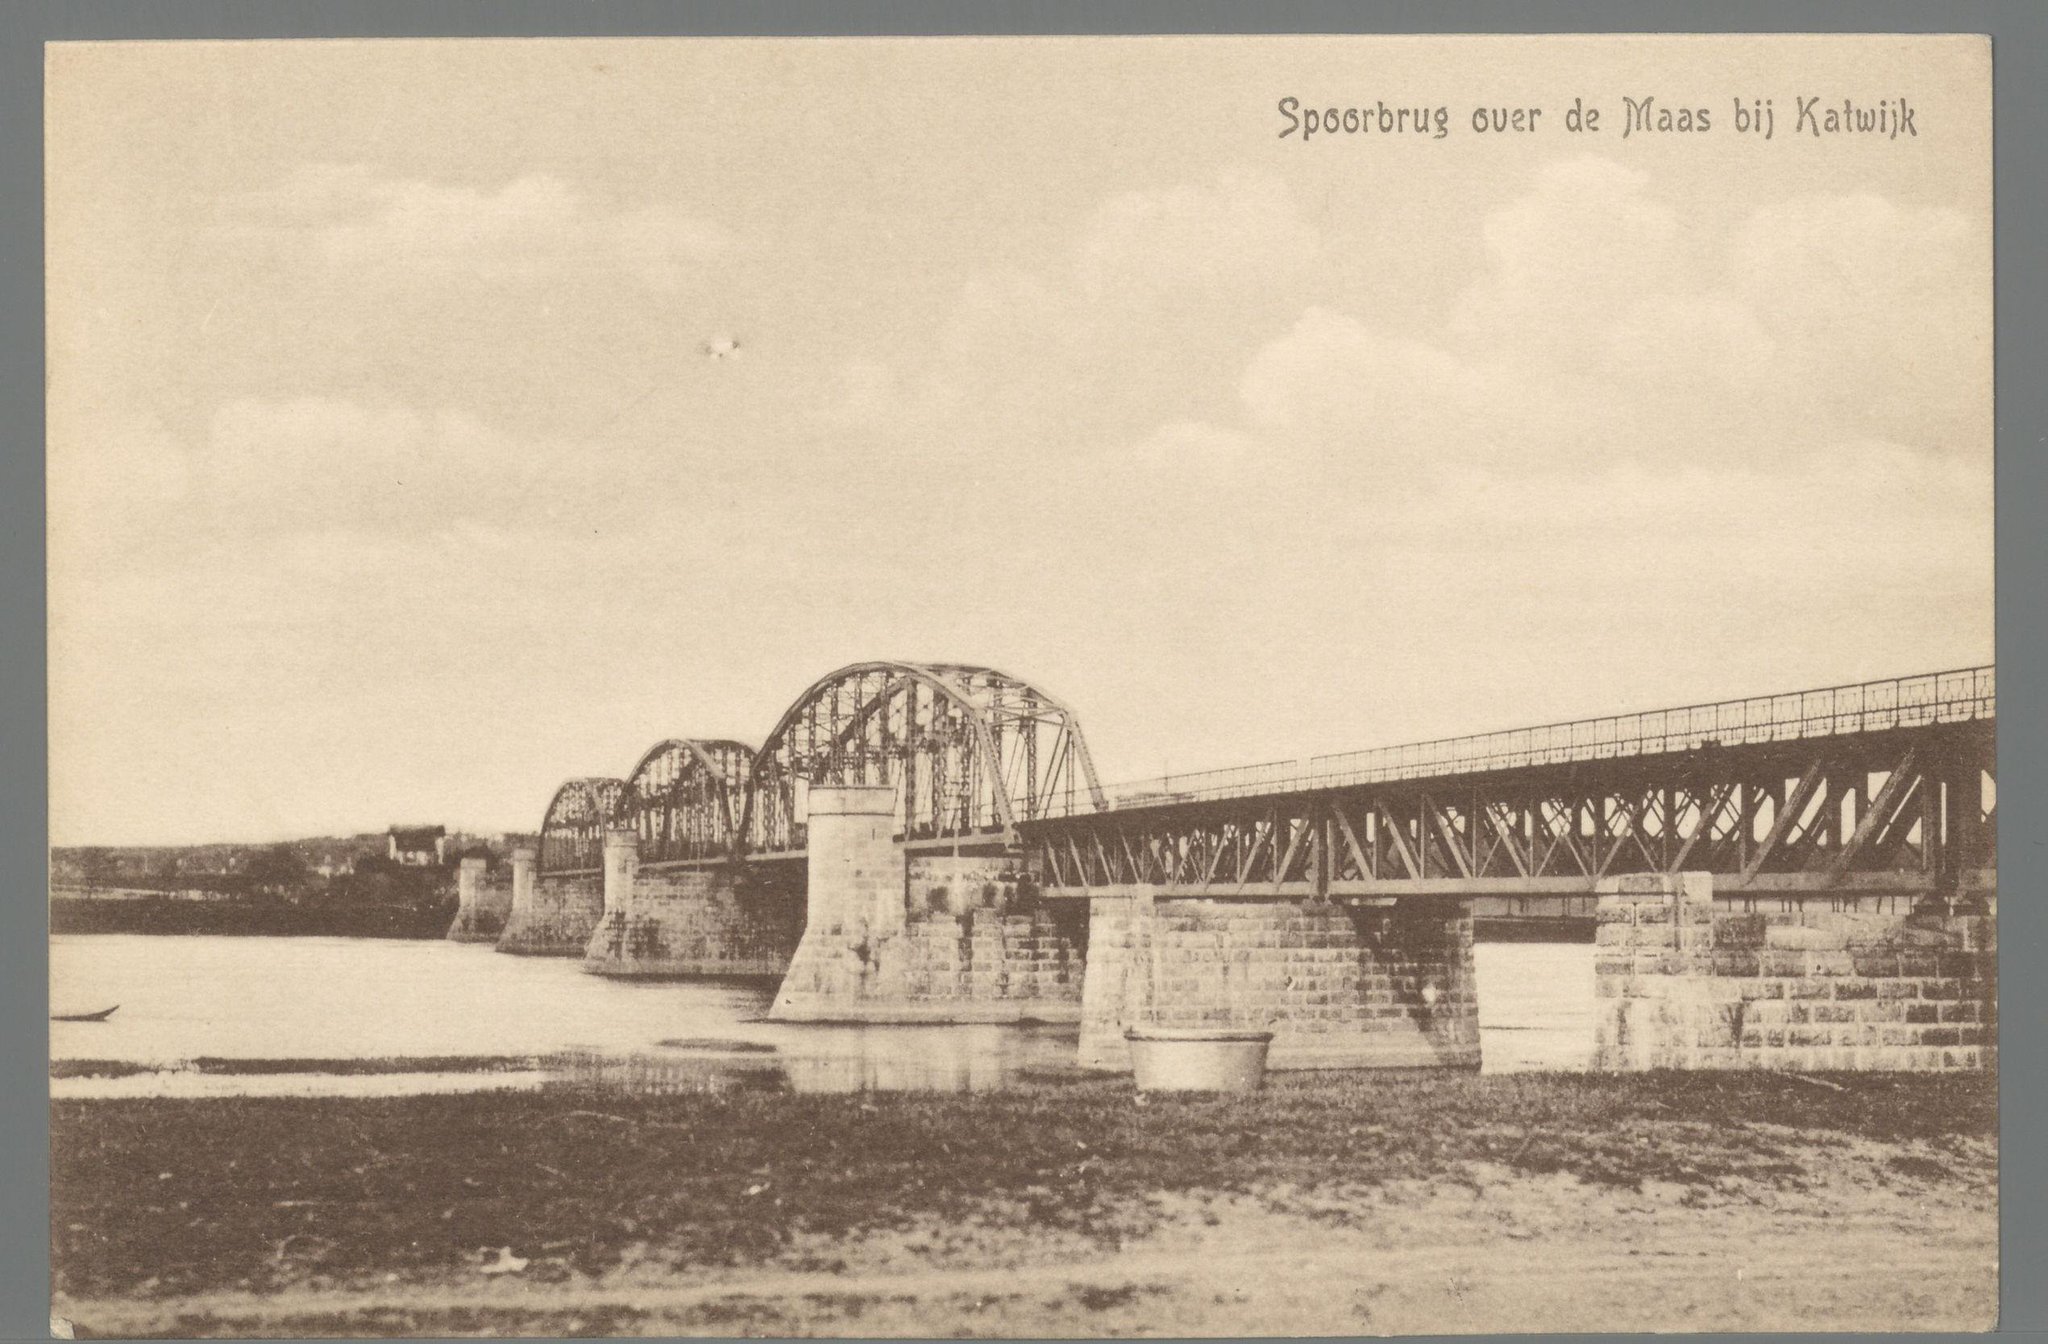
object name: ansichtkaart, prentbriefkaart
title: Spoorbrug over de Maas bij Katwijk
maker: Anonymous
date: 1905-1930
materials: cardboard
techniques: photograph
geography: katwijk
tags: river, railway, train, bridge in village across river, canal, etc.